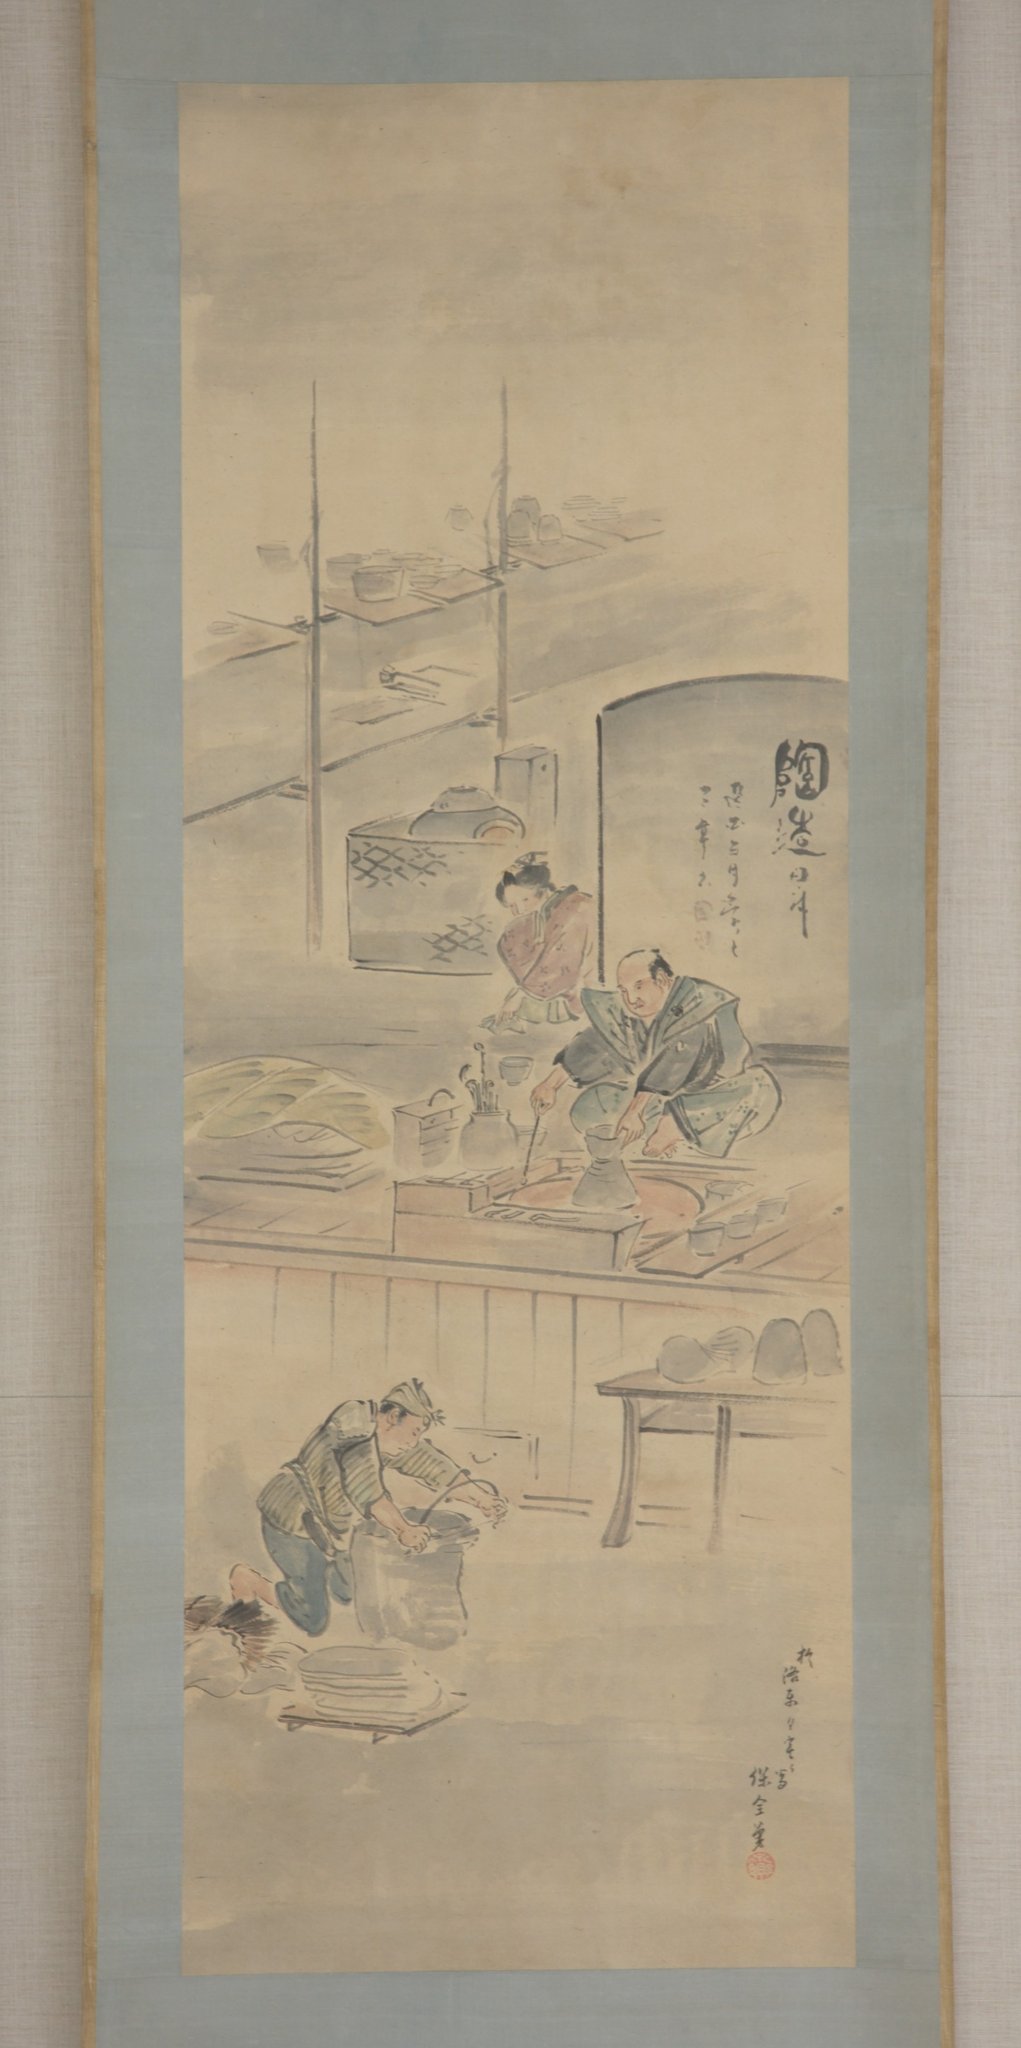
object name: hanging scroll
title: Making Ceramics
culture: japanese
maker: eiraku hozen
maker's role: artist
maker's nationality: japanese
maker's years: 1795-1854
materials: ink, paper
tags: men,working